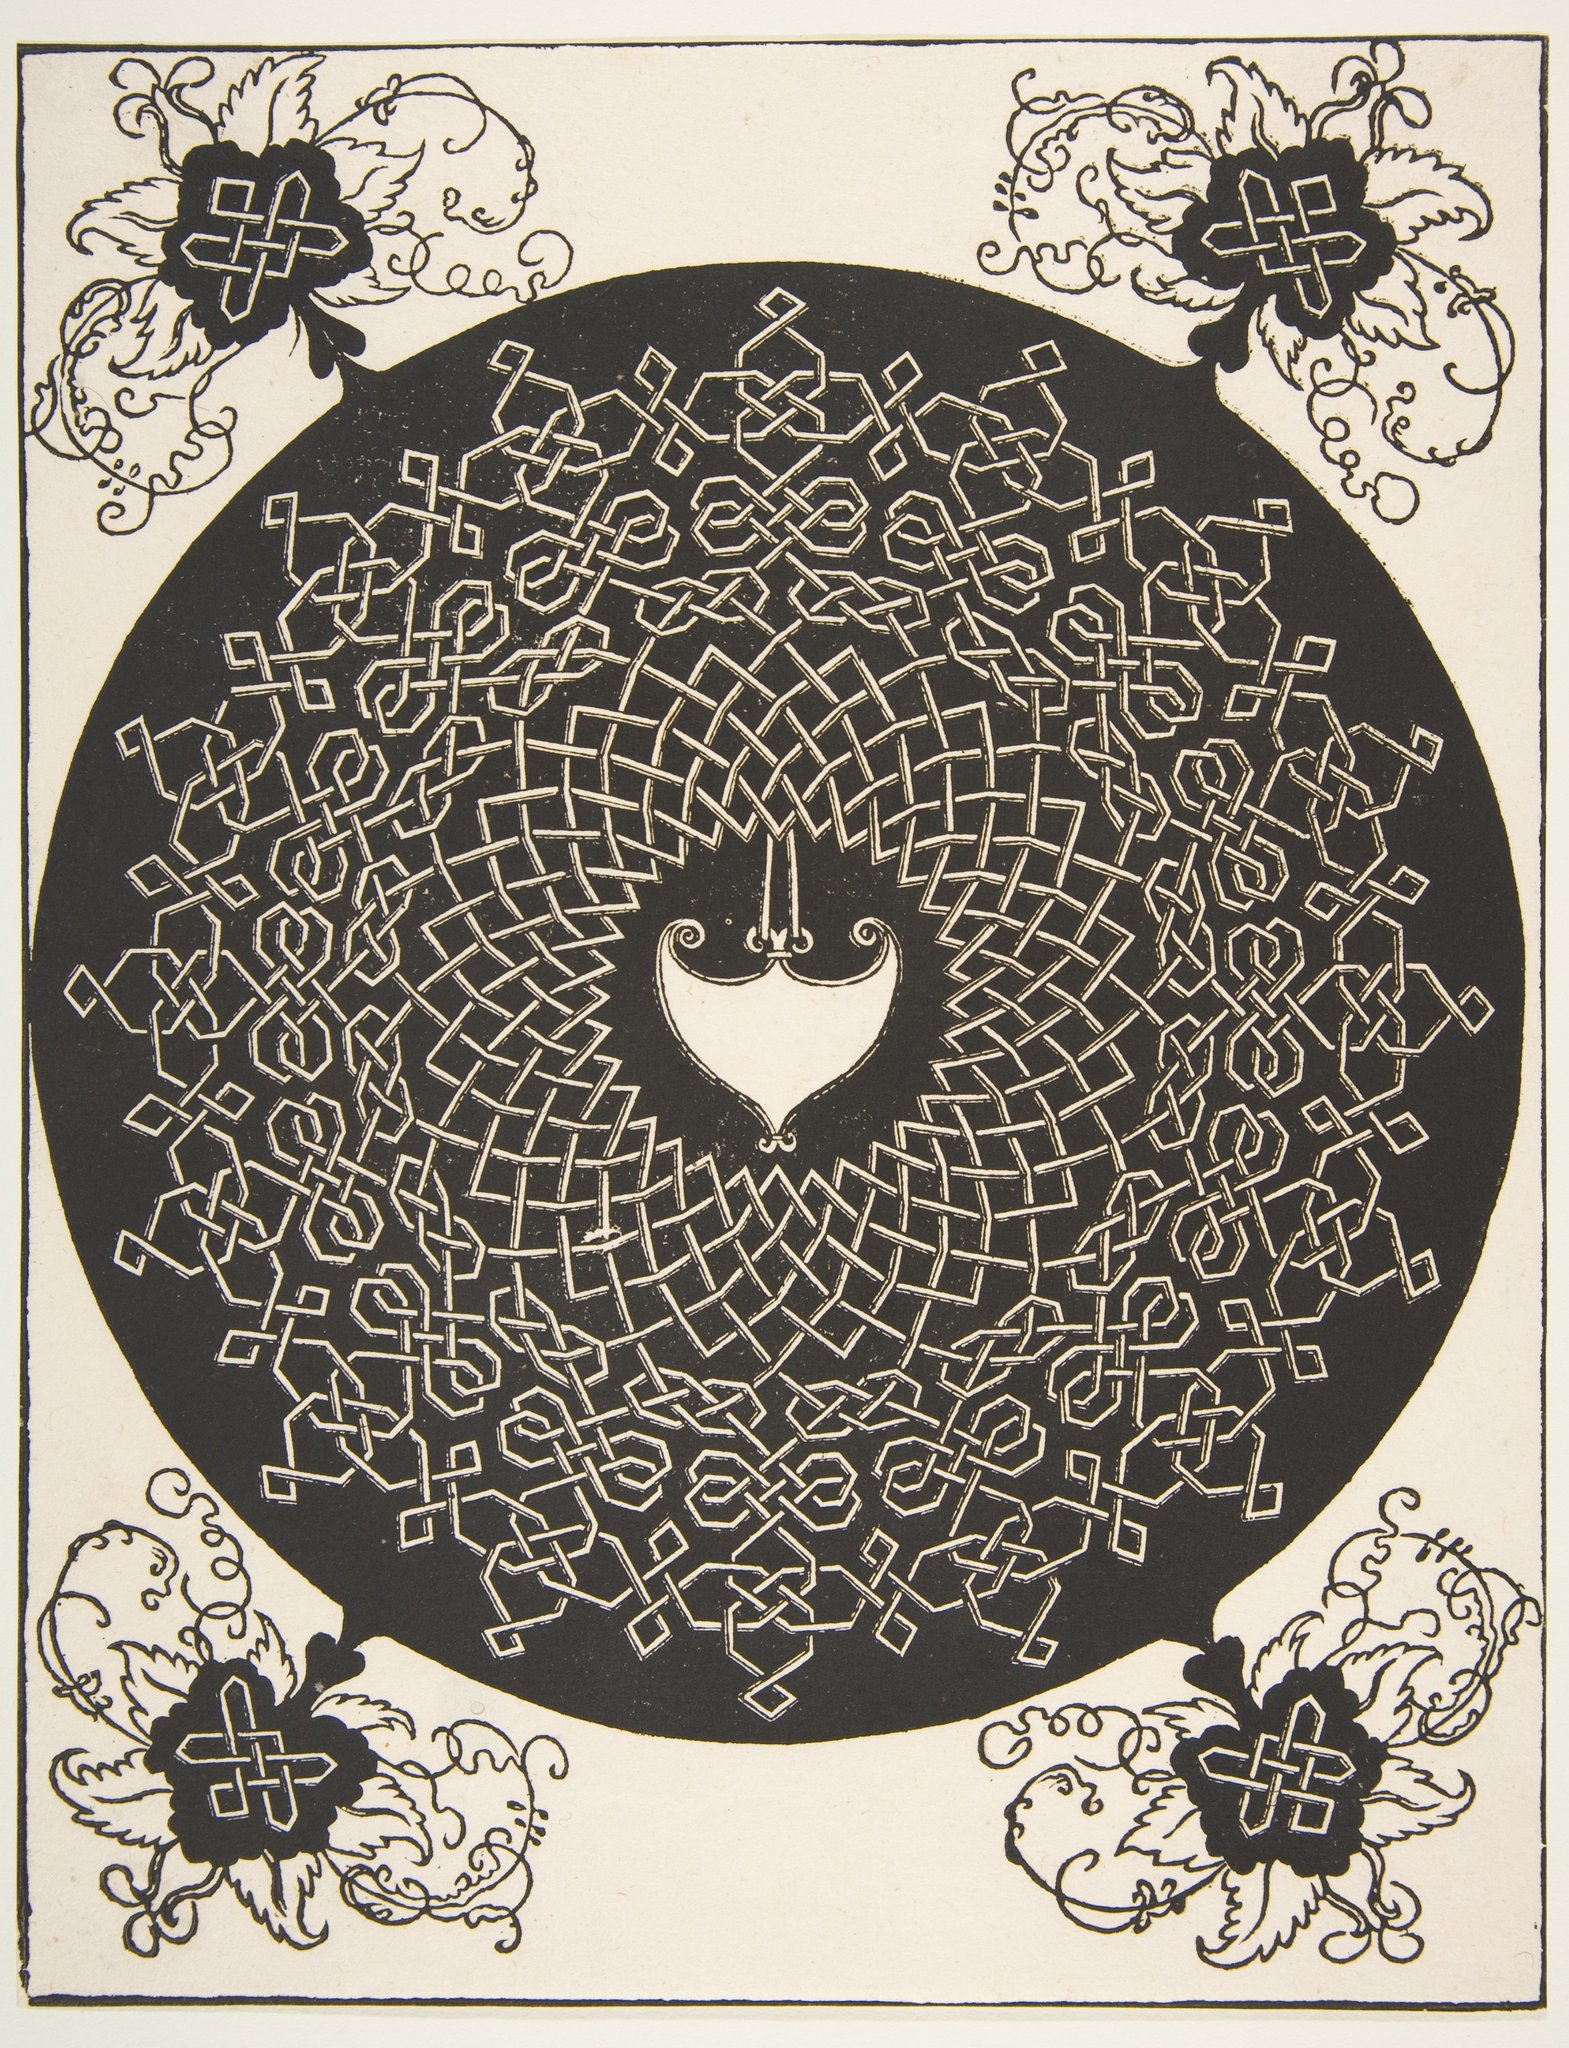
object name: collection ornament architecture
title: “The Second Knot”. Interlaced Roundel with an Amazon Shield in its Center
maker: albrecht dürer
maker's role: artist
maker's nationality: german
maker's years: 1471-1528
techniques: woodcut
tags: shields